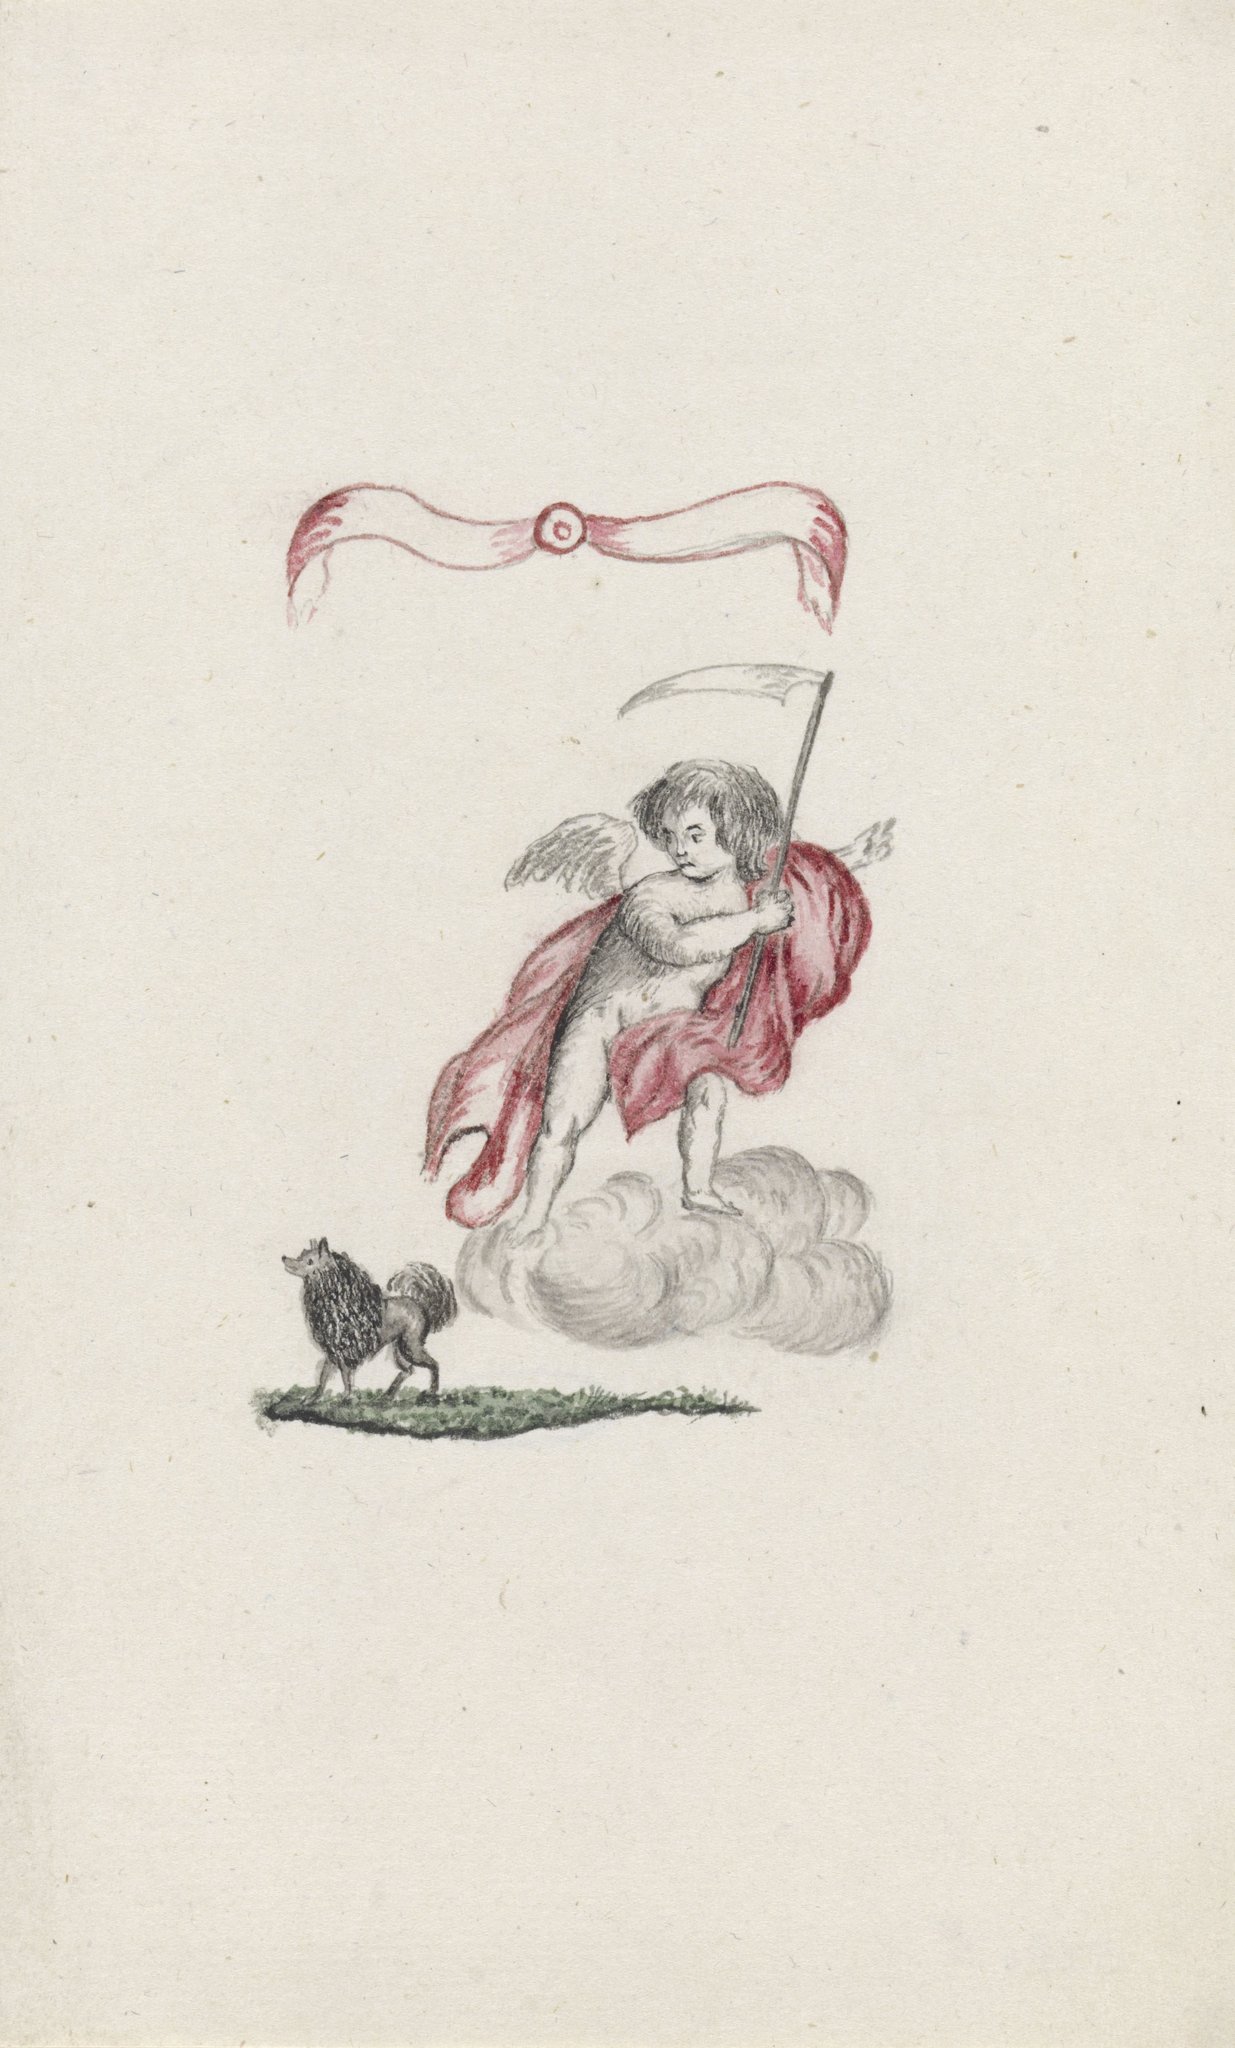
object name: drawing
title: Vignet met keeshond en roze strik, 1795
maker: Anonymous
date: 1795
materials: paint, paper, pencil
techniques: brush, pen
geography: netherlands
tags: dog, alliance with france (1795)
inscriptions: collector's mark: Lugt 2228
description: Vignet met een keeshond bij een putto die met een zeis op een wolk staat. Bovenaan een roze strik. Onderdeel van een groep van zes getekende vignetten, mogelijk voor chasinetten bij een feest ter gelegenheid van de alliantie met Frankrijk in 1795.